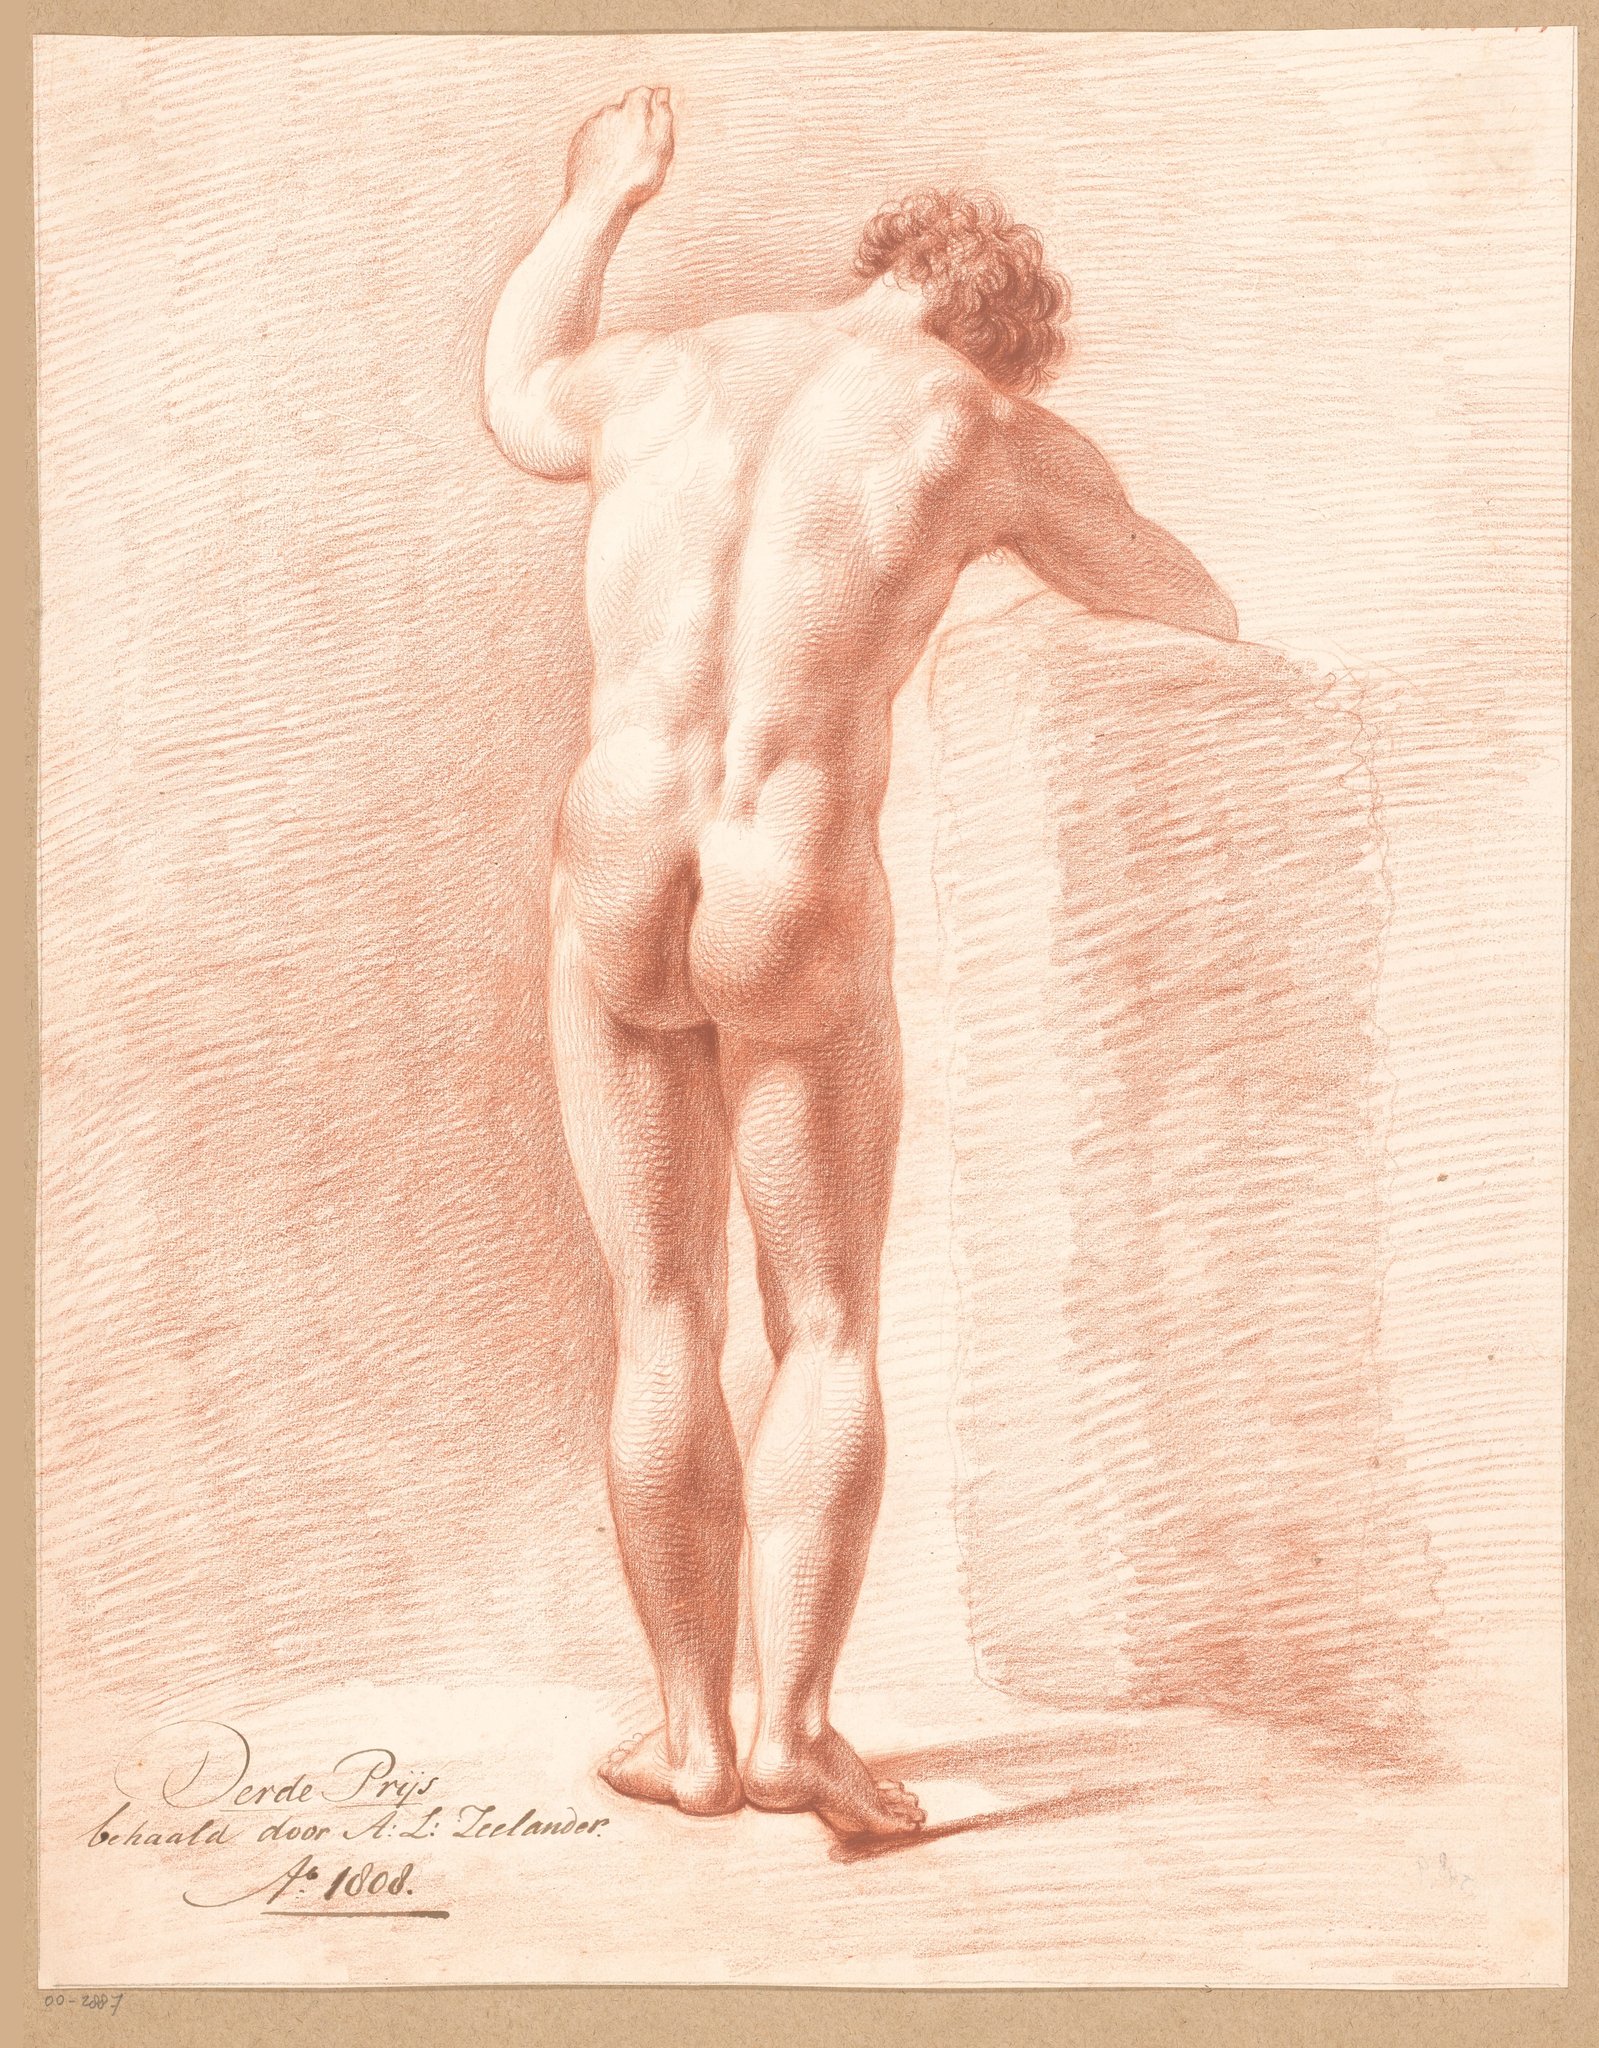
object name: drawing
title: Staand mannelijk naakt, op de rug gezien (3e prijs 1808)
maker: abraham lion zeelander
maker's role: draughtsman, print maker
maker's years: 1789-1856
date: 1808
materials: chalk, paper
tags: standing figure (+ nude human being)